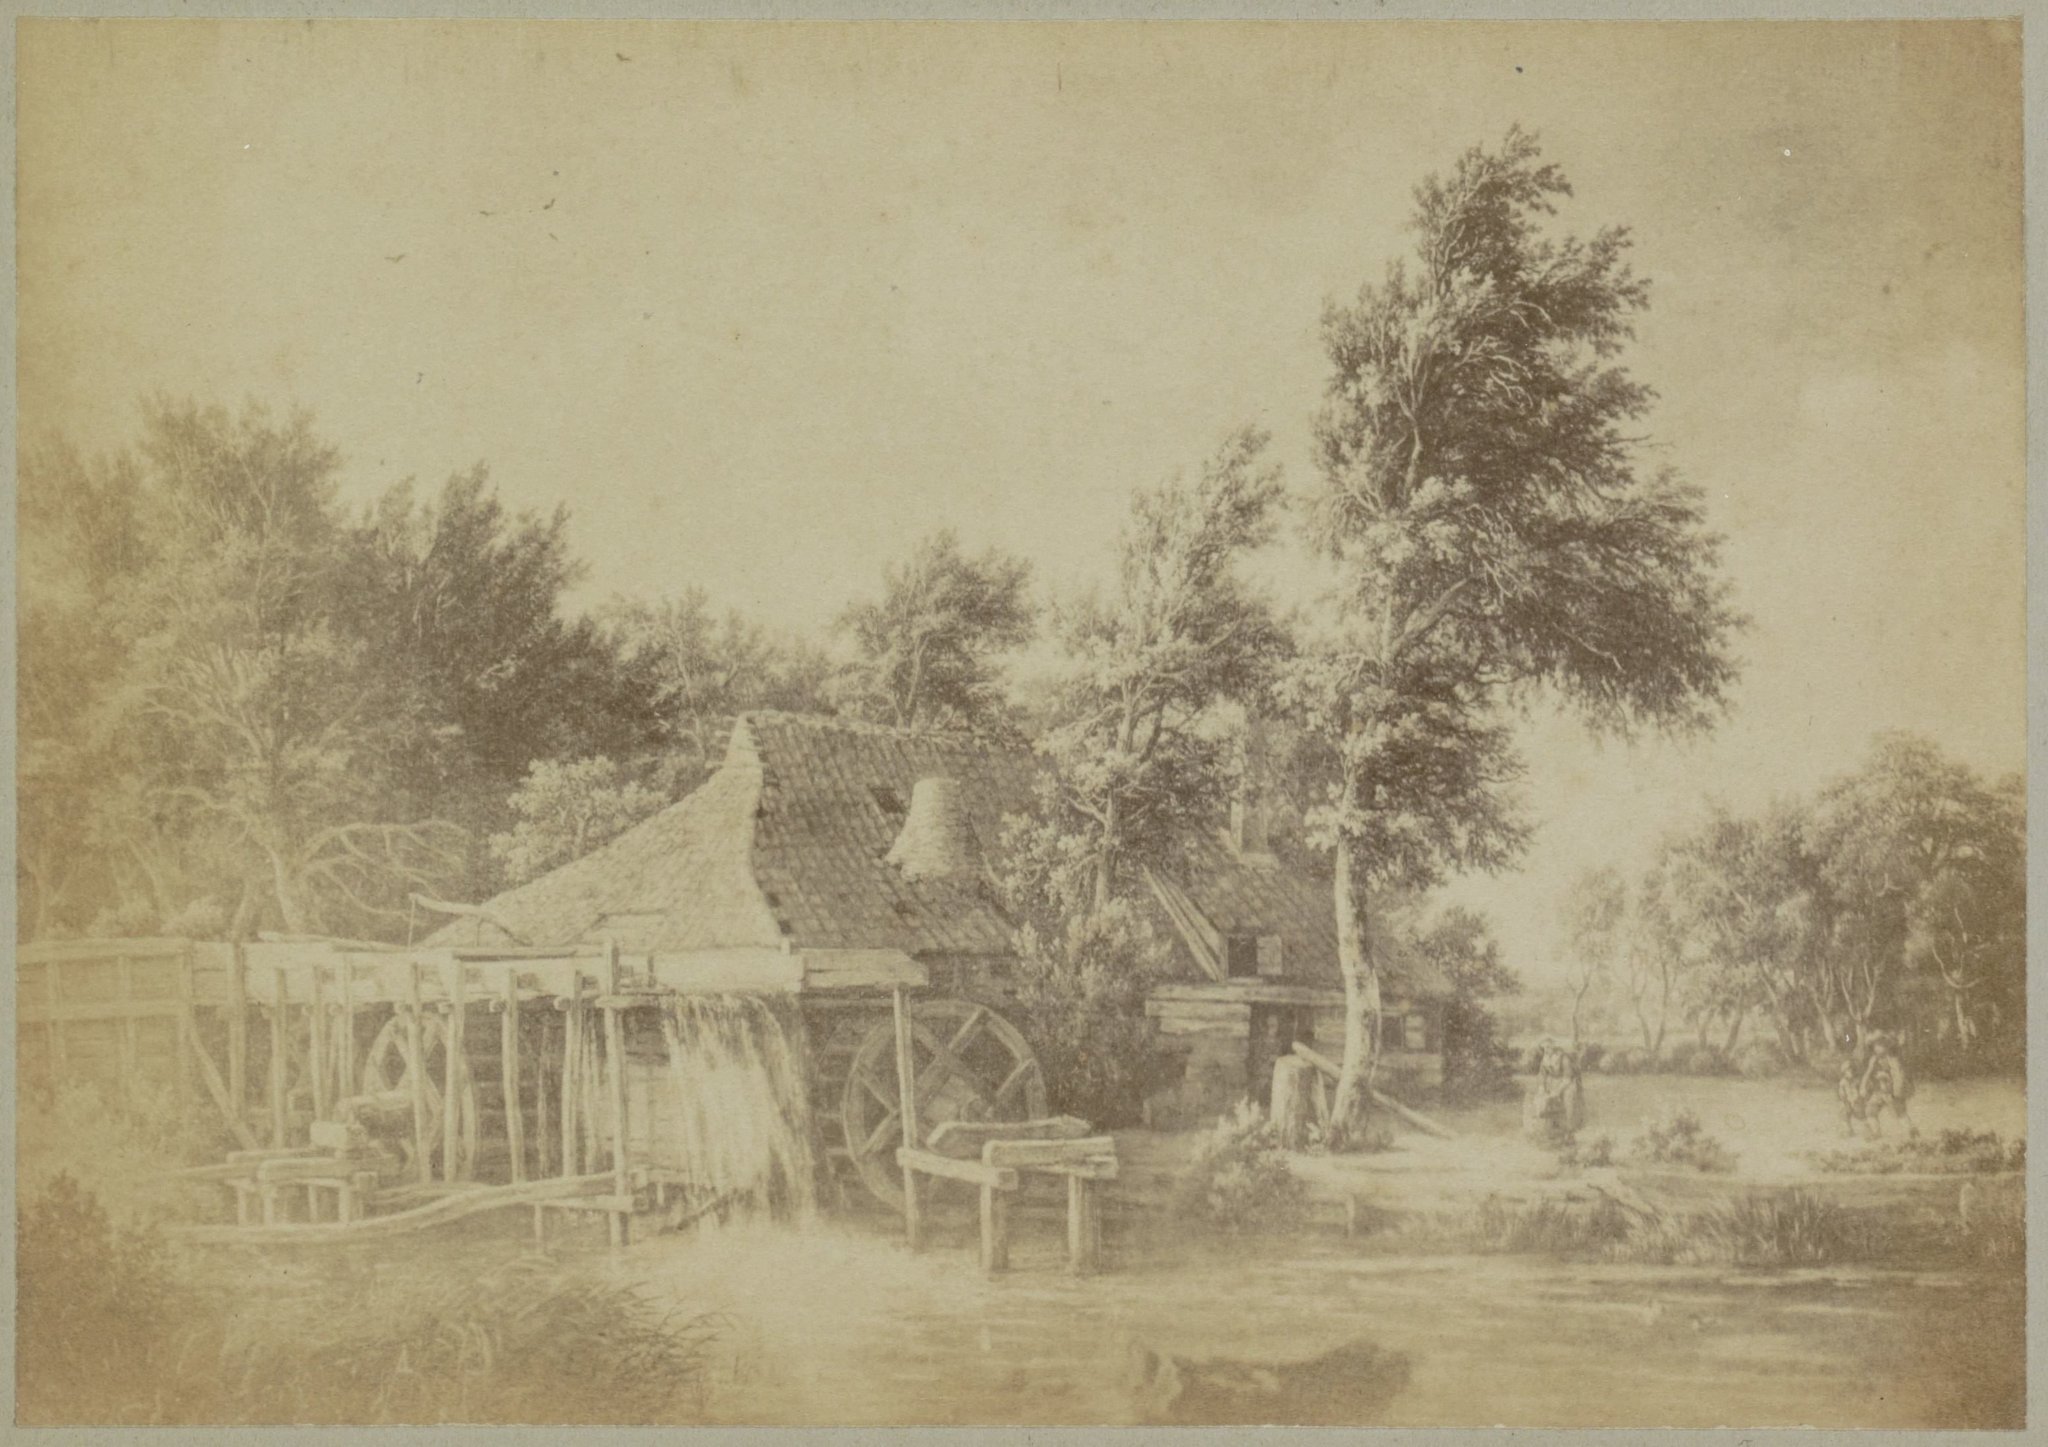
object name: photograph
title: Musée d'Amsterdam. Meindert Hobbema. - Le Moulin à eau.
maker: johan marinus schalekamp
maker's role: publisher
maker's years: 1844-1912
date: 1893-1912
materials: cardboard, photographic support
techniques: albumen print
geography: amsterdam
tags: picture, painting, watermill in landscape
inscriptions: number: ‘19’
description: Onderdeel van Leporelloalbum met fotoreproducties van schilderijen uit het Rijksmuseum.